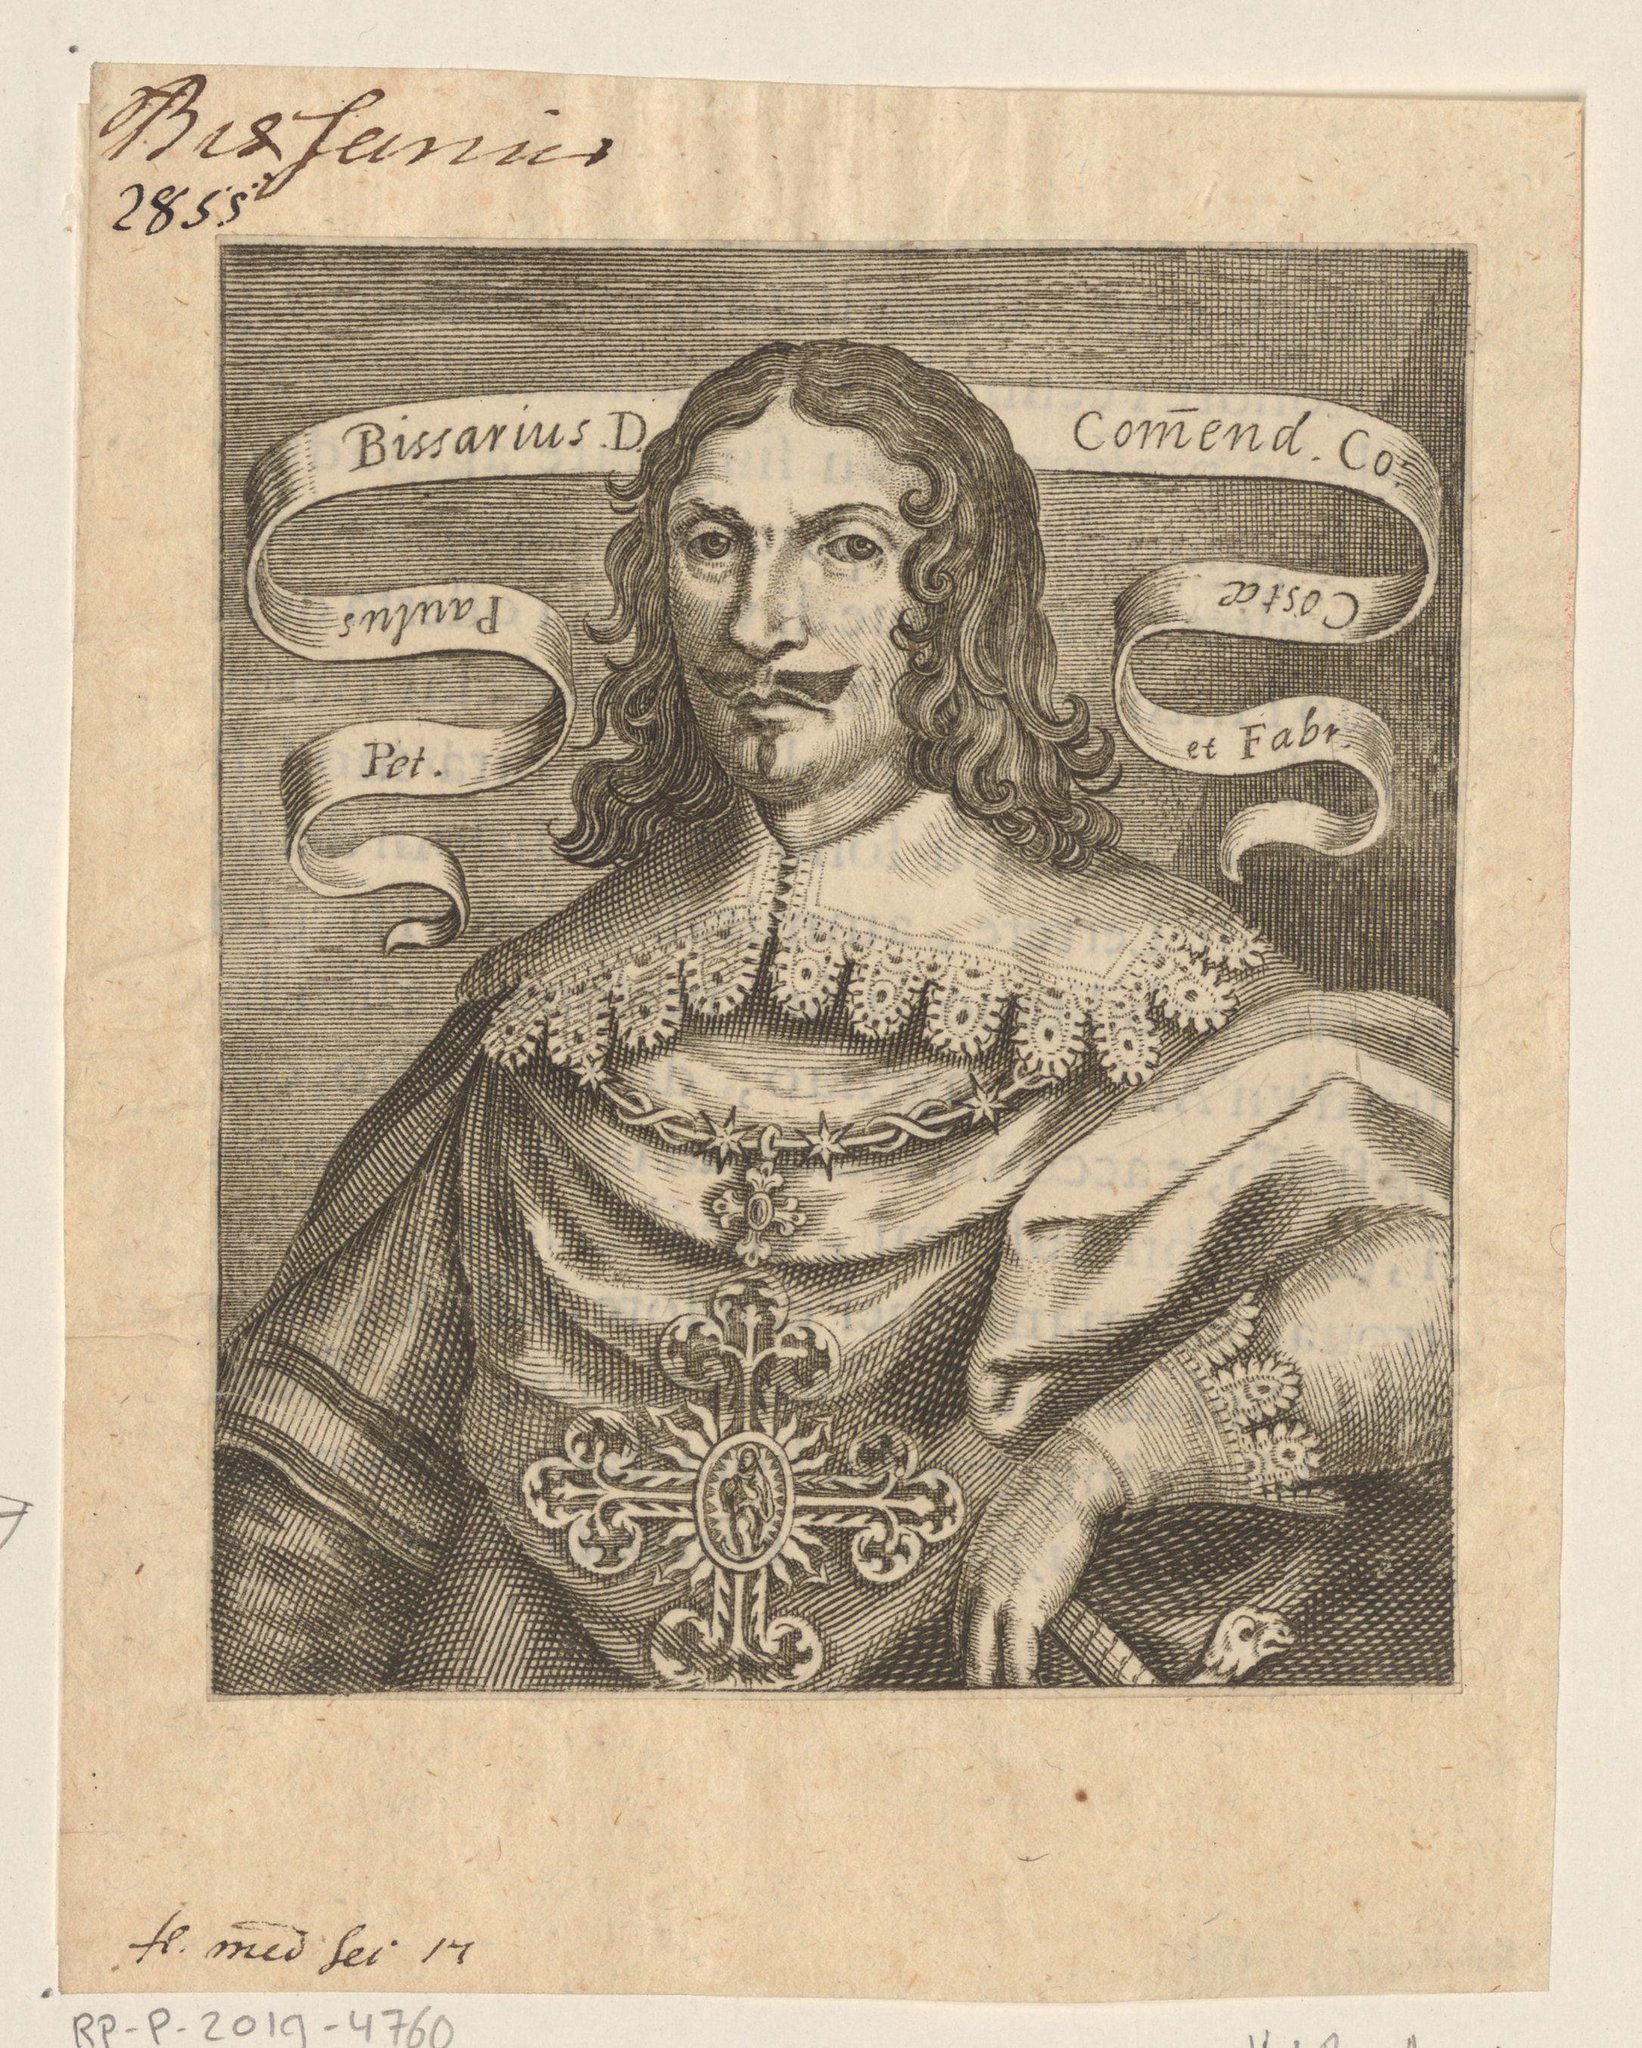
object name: print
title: Portret van Pietro Paolo Bissari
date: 1647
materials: paper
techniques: engraving, etching, letterpress printing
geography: venice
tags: historical persons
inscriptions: inscription: ‘Bissanius 2855 [...]’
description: Prent uit: Le glorie de gli incogniti o vero gli huomini illustri dell'accademia de' signori incogniti di Venetia. Venetië: Francesco Valvasense,1647, p. 380.